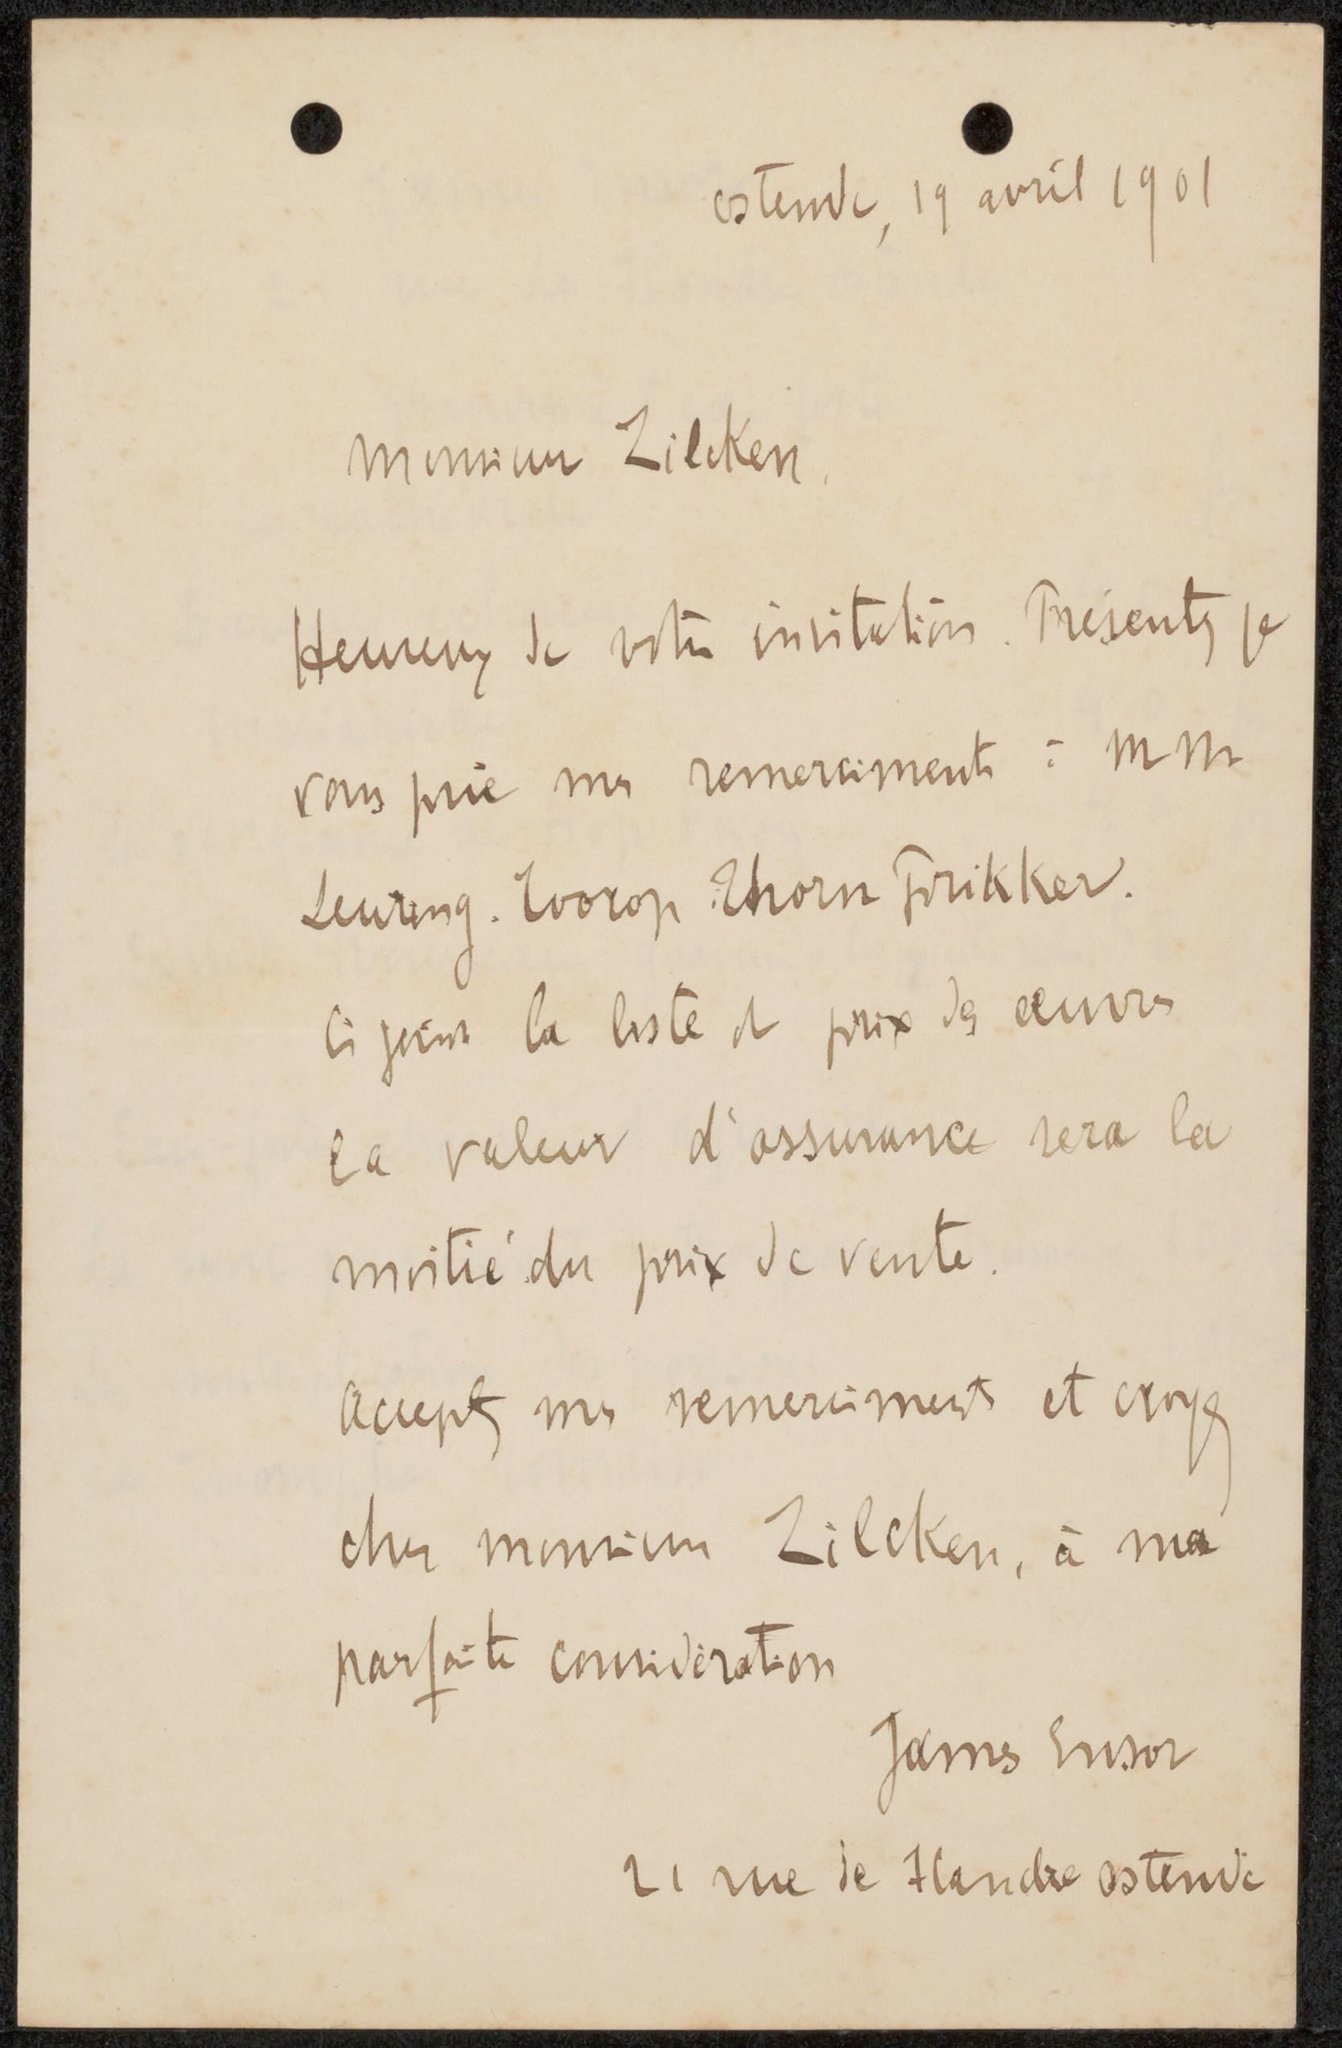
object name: letter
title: Brief aan Philip Zilcken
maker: james ensor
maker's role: print maker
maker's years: 1860-1949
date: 1901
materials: ink, paper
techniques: pen, writing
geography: oostende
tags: the hague, painter, draughtsman, philip zilcken, the graphic arts, money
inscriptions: collector's mark: ‘RPK’, watermark